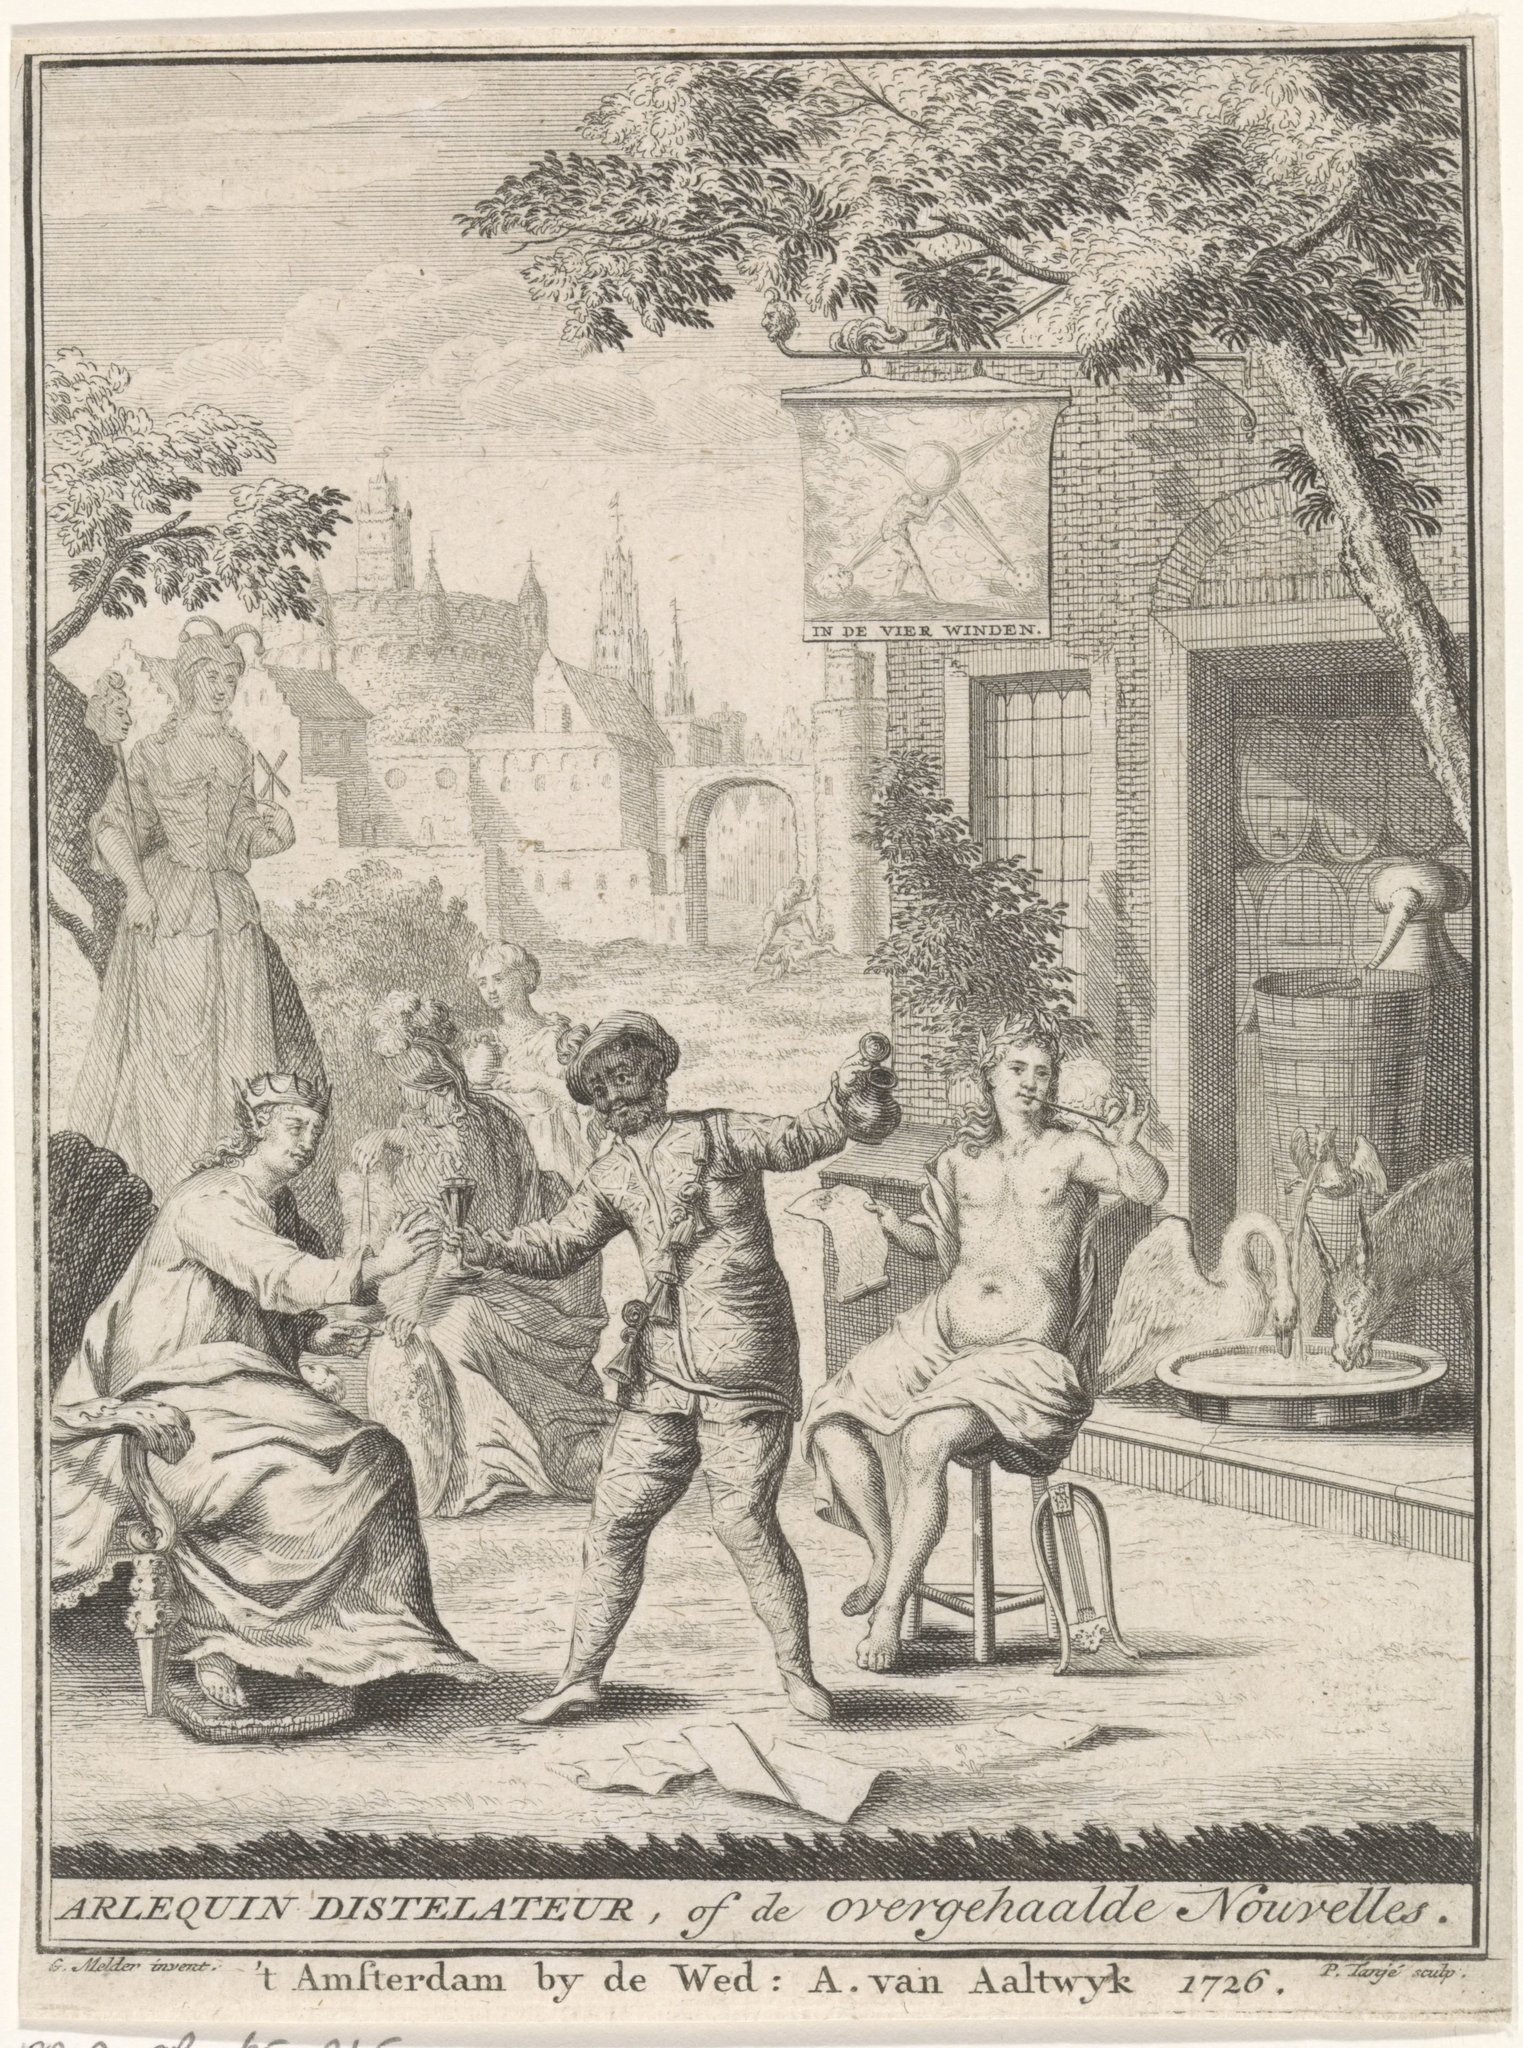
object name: print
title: Harlekijn als destillateur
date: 1726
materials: paper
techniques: engraving, etching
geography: amsterdam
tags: types in 'commedia dell'arte': harlequin, distilled spirits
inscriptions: collector's mark: Lugt 2228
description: Titelpagina voor: Zutphen, Pelgrom van. Pseud. van Wilhelmus van Swaanenburg. Arlequin distelateur, of De overgehaalde nouvelles; zynde een werk immers zo dwaas (...) dewyl het (...) vertoont alle de hokken van het dolhuis dezer geheele wéreld. Amsterdam: Antony van Aeltwijk (wed.), 1726.